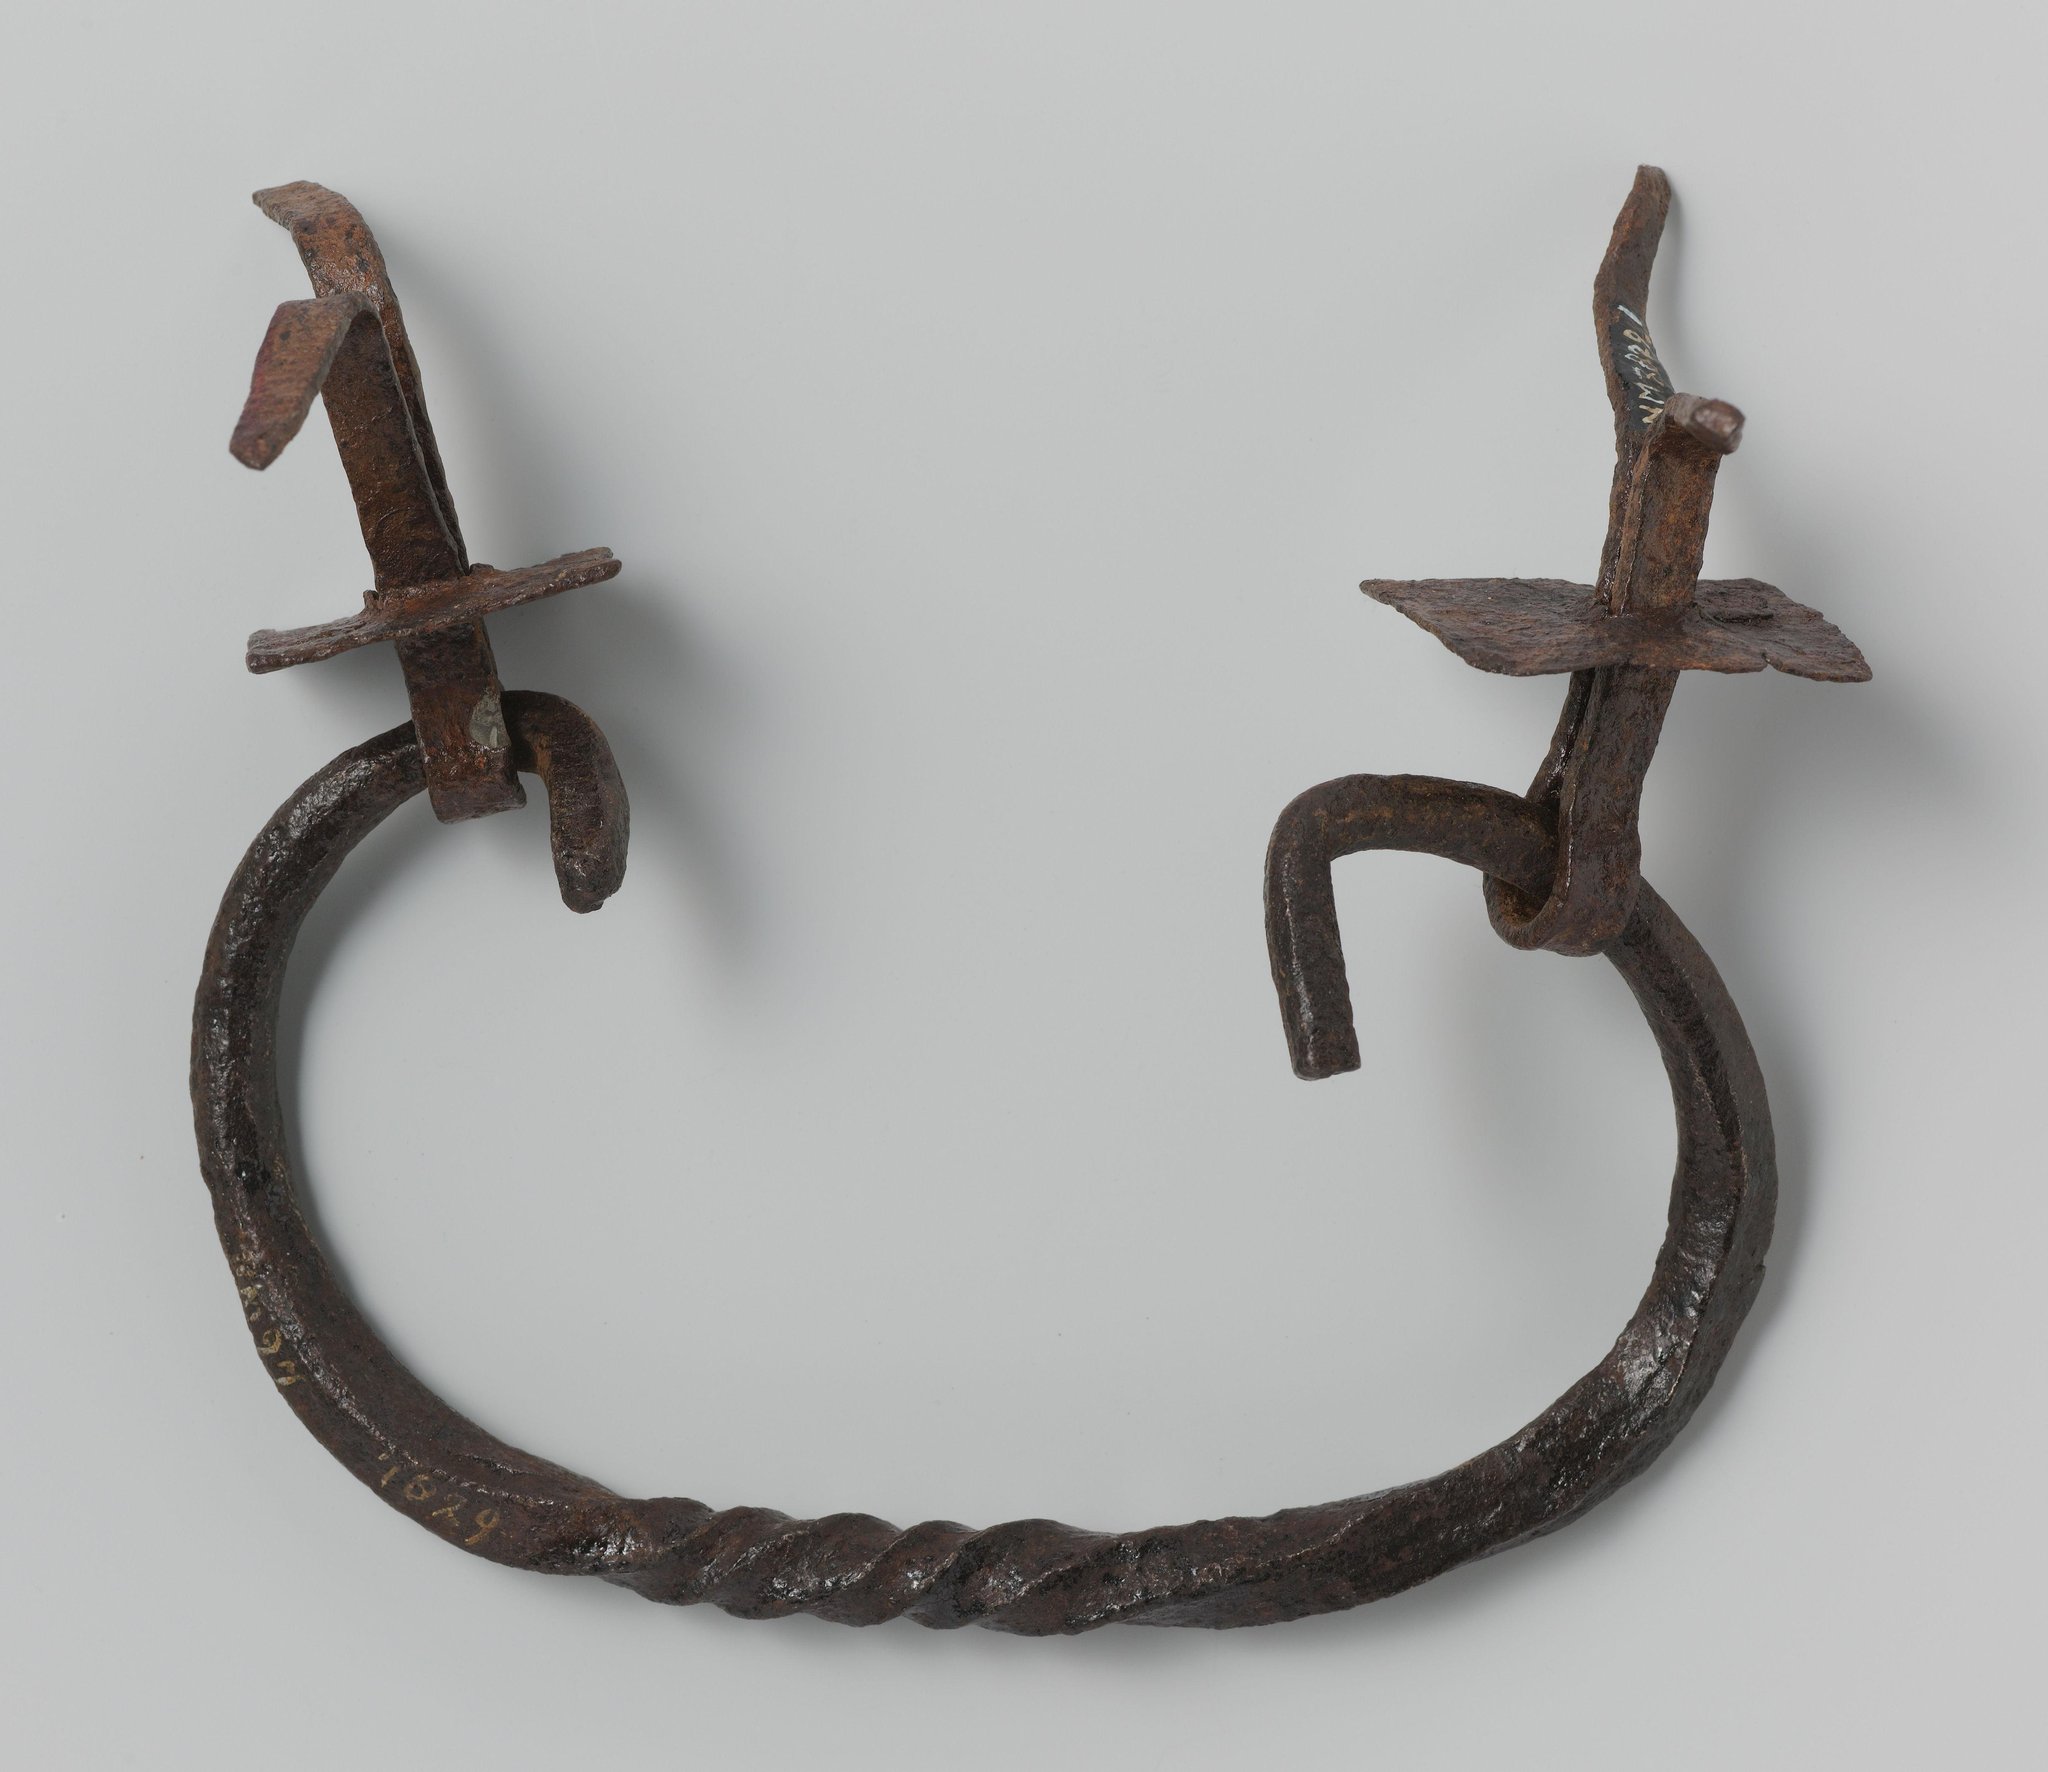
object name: chest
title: Ovale en getordeerde handgreep van een kist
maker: Anonymous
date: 1590-1596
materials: iron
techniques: forging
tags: willem barendsz., amsterdam, jacob van heemskerck